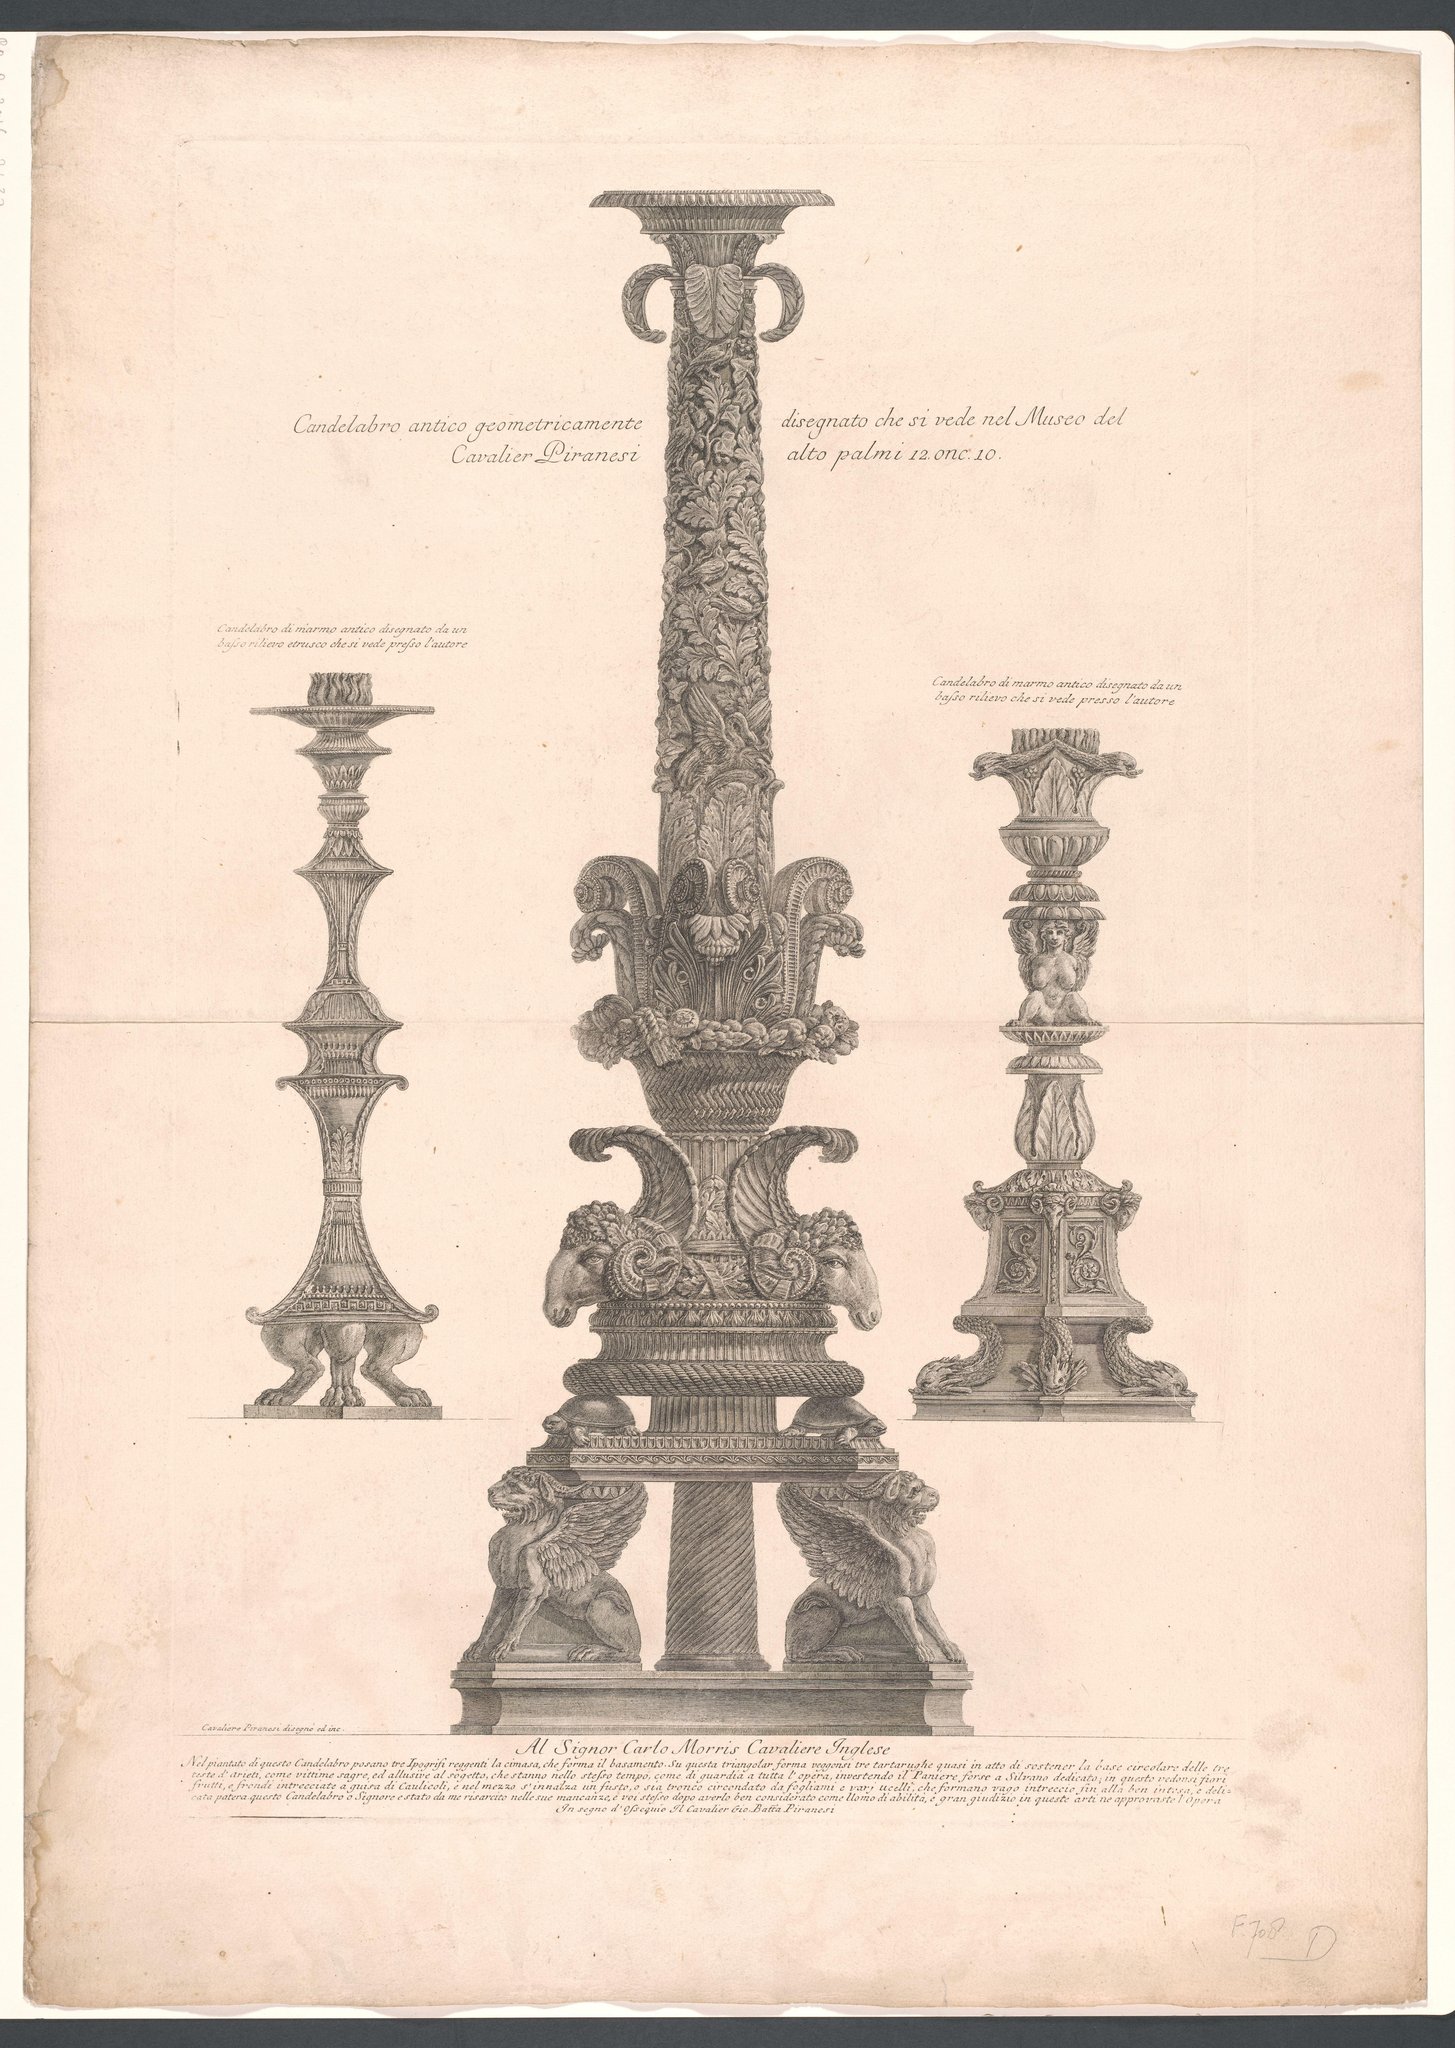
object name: ornament print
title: Vasi, candelabri, cippi, sarcofagi, tripodi, lucerne, ed ornamenti antichi disegn. ed incisi dal cav. Gio. Batta Piranesi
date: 1778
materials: paper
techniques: etching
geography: rome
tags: chandelier, candelabrum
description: De 'Vasi'-reeks telt 110 prenten, verspreid over twee volumes met elk een eigen titelprent. Piranesi werd voor deze reeks geholpen door verschillende assistenten uit zijn werkplaats, waaronder zijn zoon Francesco die ook nog eens 8 platen toevoegde aan de reeks in 1779-1780.